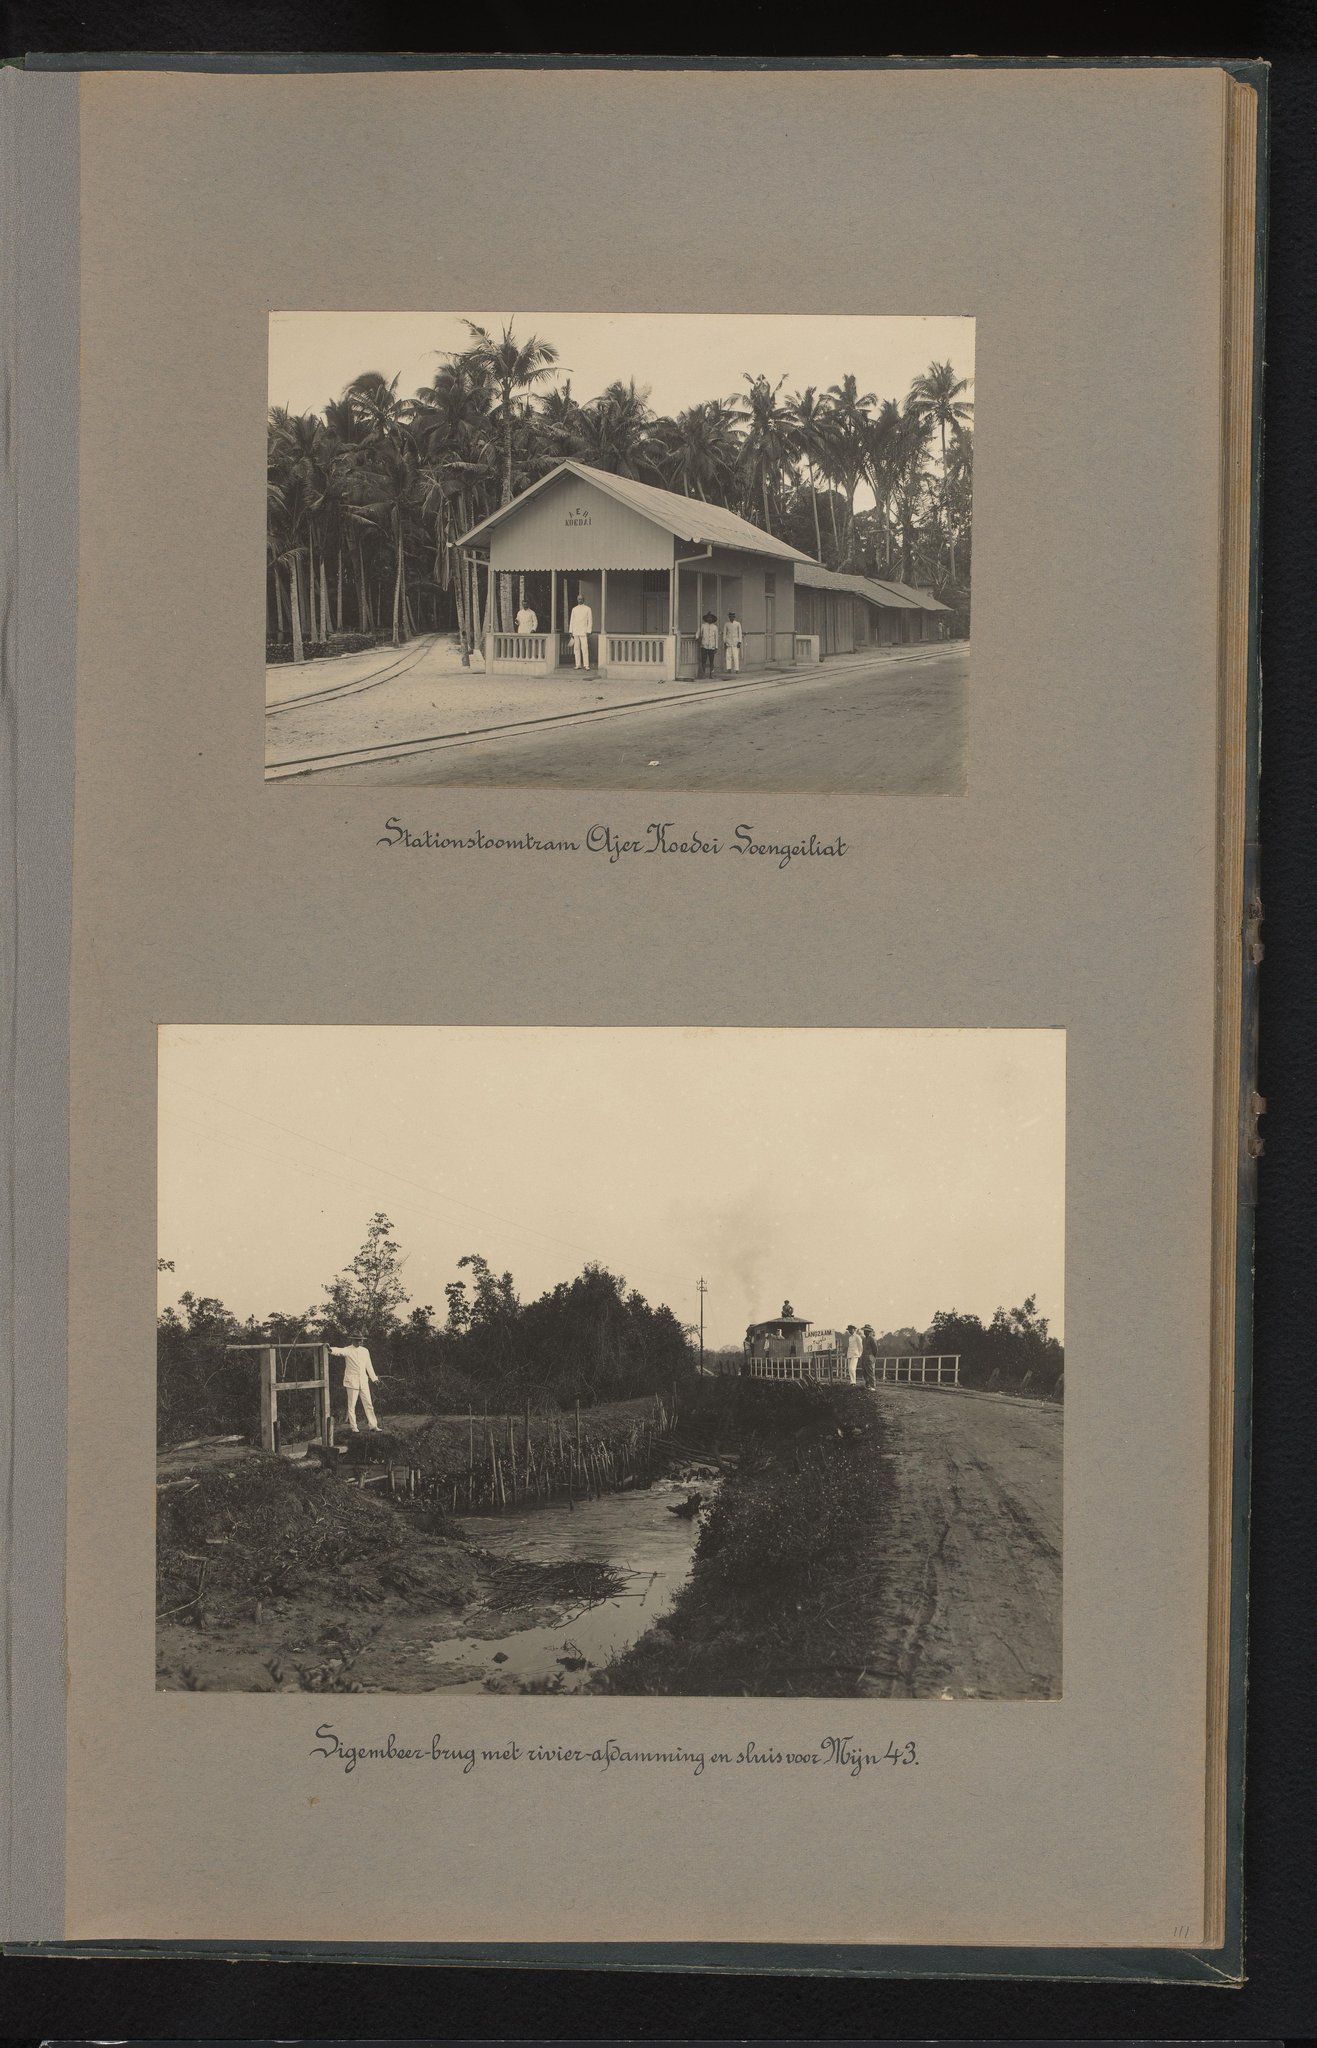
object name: photograph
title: Station van de stoomtram en brug met sluis van de Banka-tinwinning te Soengeiliat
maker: Anonymous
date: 1914-1919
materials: cardboard, photographic support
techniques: gelatin silver print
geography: bangka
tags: robert julius boers, sluice, weir, colonial system, mining, railway, tramway; rack railway (+ propulsion of vehicle, ship, etc. by steam), station; shelter (railway, tramway)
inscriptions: inscription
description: Albumblad met 2 foto's van het station van de stoomtram en van een brug met sluis van de Banka-tinwinning te Soengeiliat. Onderdeel van het fotoalbum aangeboden aan Robert Julius Boers bij zijn vertrek naar Nederland in 1919 door het personeel van de Banka-tinwinning.